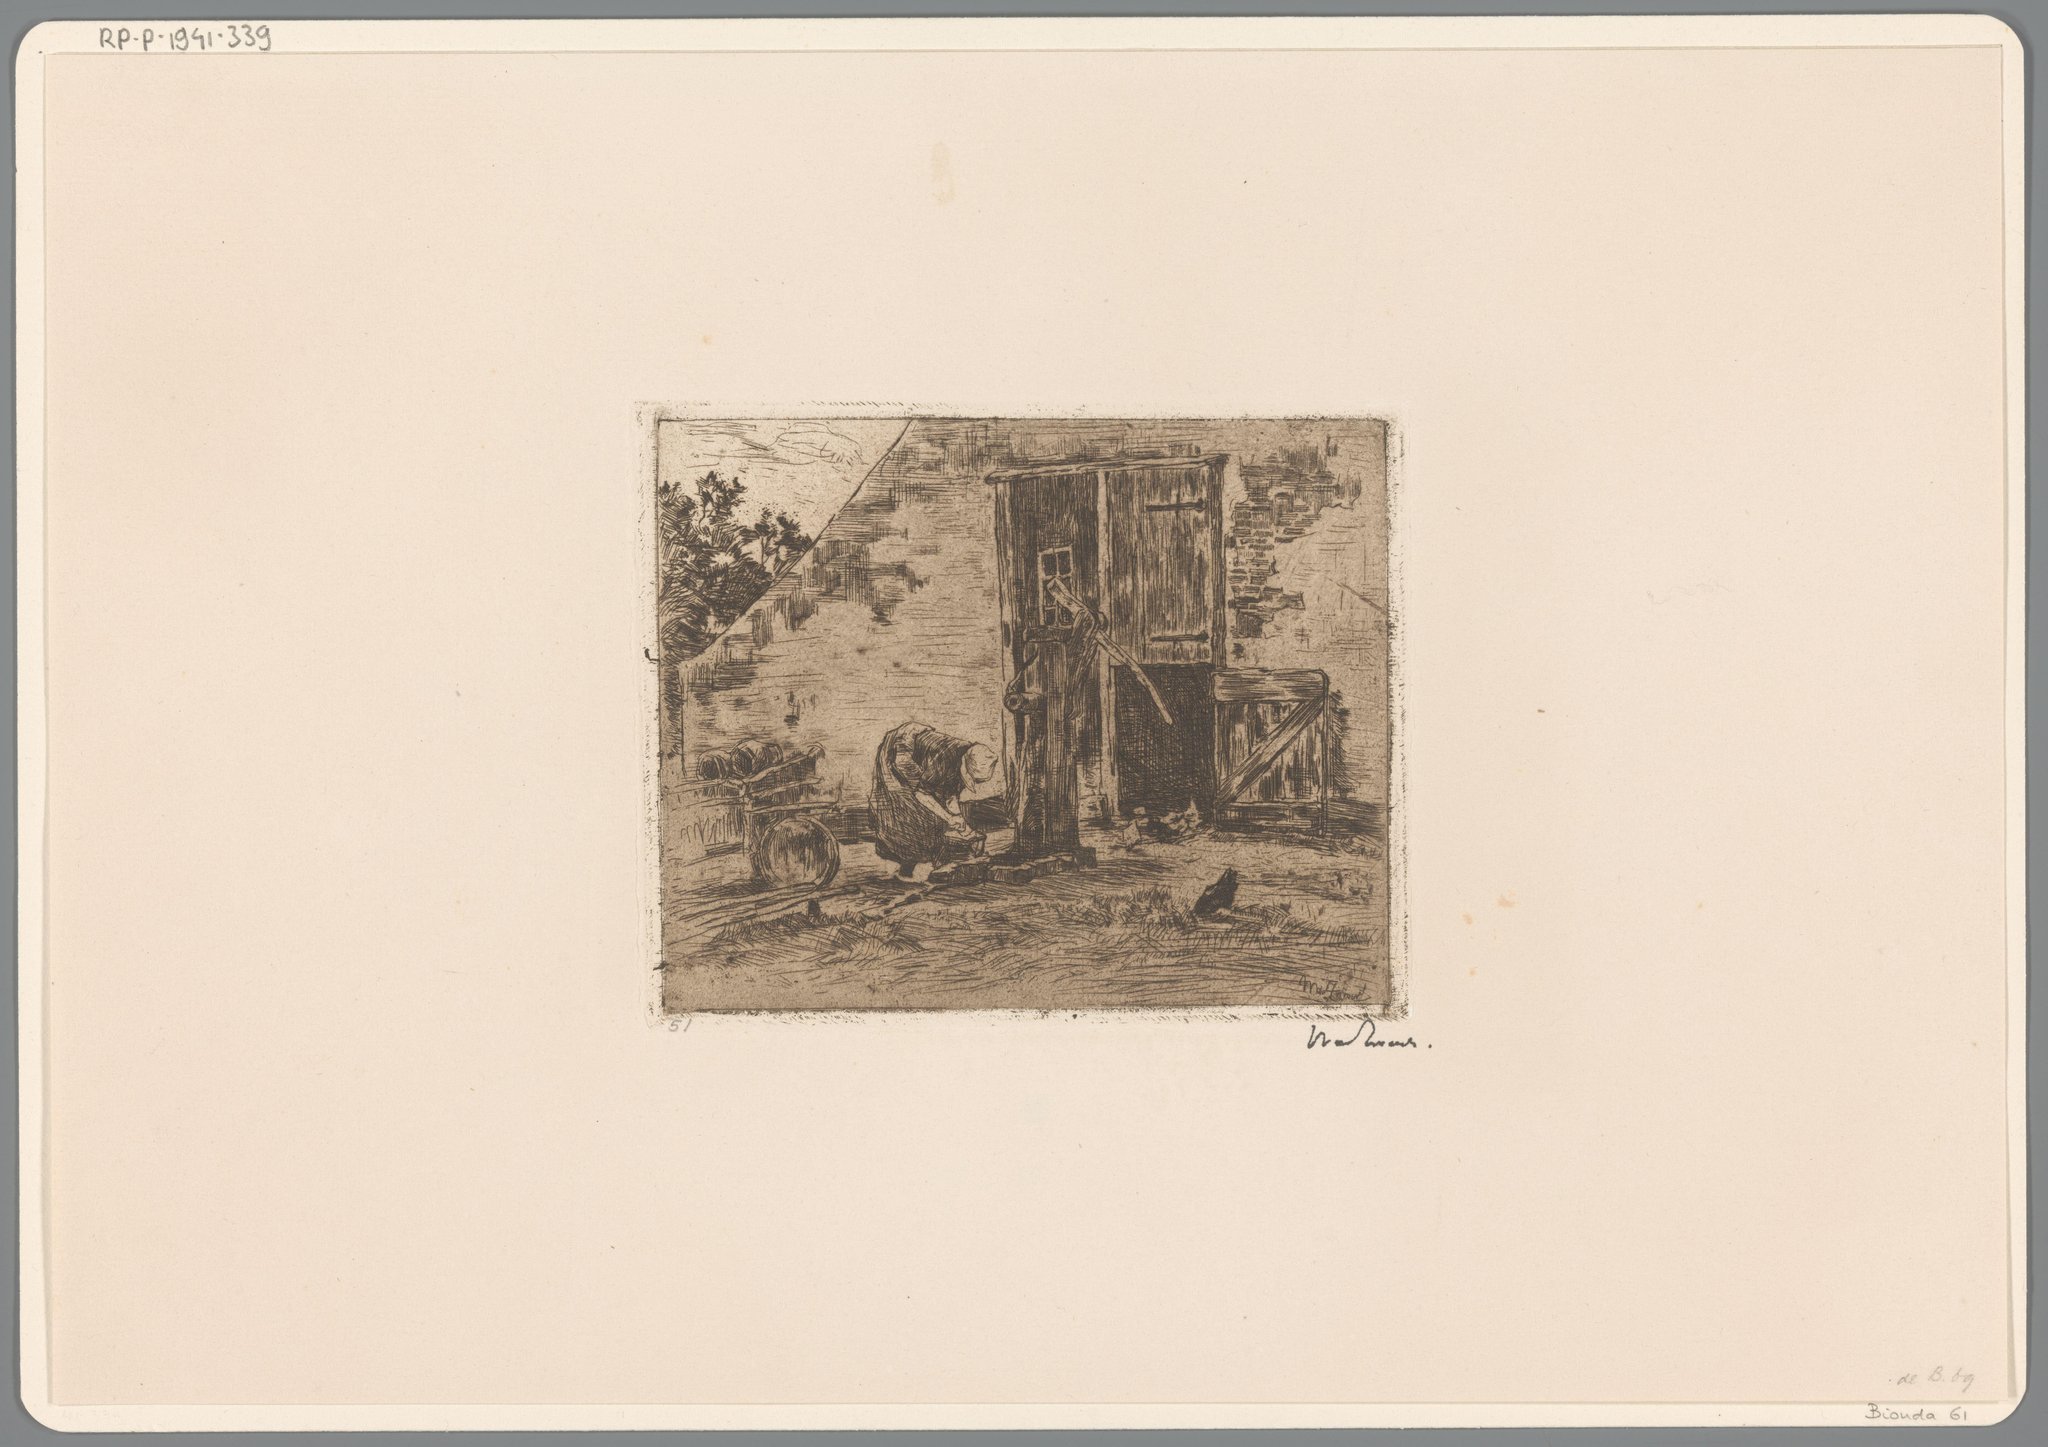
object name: print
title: Vrouw bij een waterpomp voor een boerderij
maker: willem de zwart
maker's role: draughtsman, painter, print maker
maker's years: 1862-1931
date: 1896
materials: paper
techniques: etching, intaglio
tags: pump, farm or solitary house in landscape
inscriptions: collector's mark: Lugt 2760, collector's mark: Lugt 2228